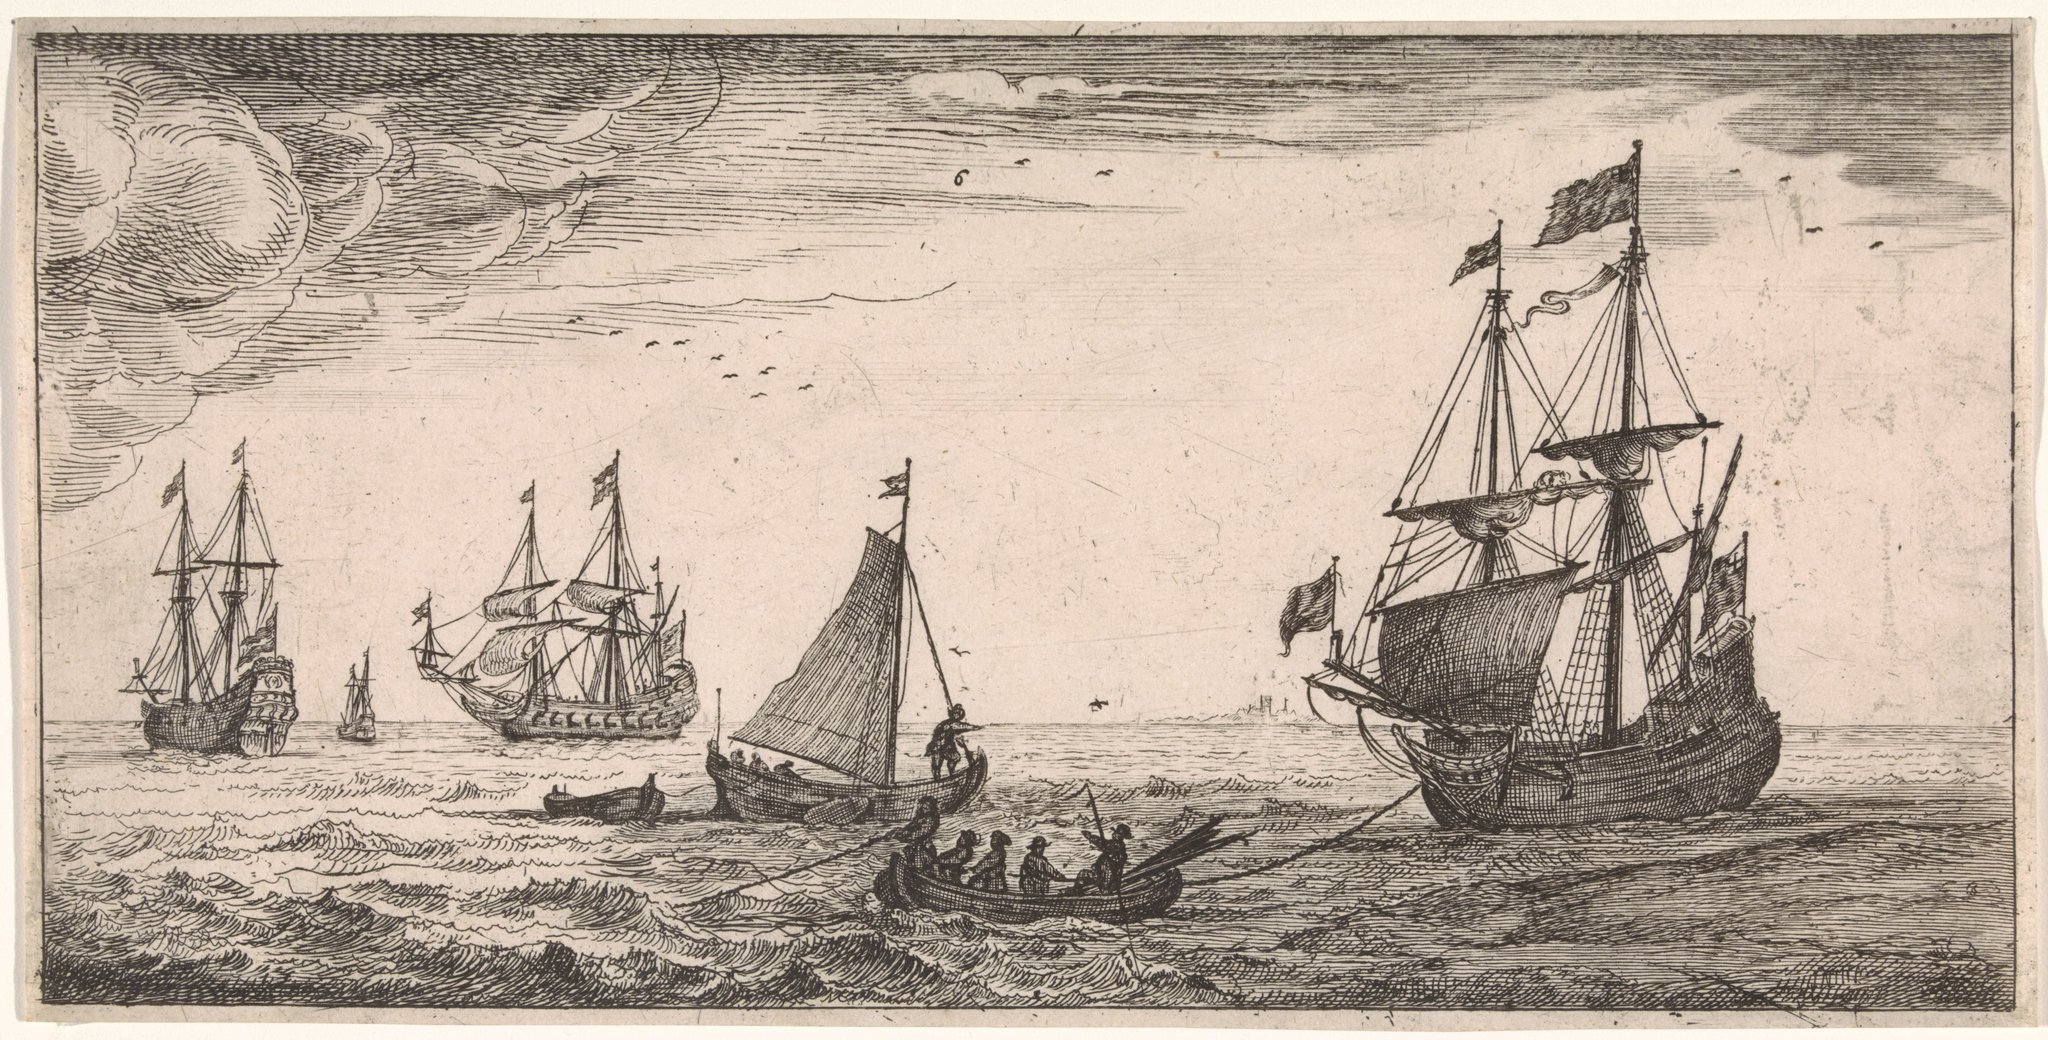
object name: print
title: Schepen op zee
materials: paper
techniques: engraving, etching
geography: rotterdam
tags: postal service, ships (in general) (+ arrival, coming to anchor, at anchor), ships (in general) - cc - more than one ship, sea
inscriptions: collector's mark: Lugt 2228, collector's mark: Lugt 1206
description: Enkele schepen op zee. Een van de matrozen van een zeilschip wijst naar de plaats waar het anker moet worden uitgegooid.